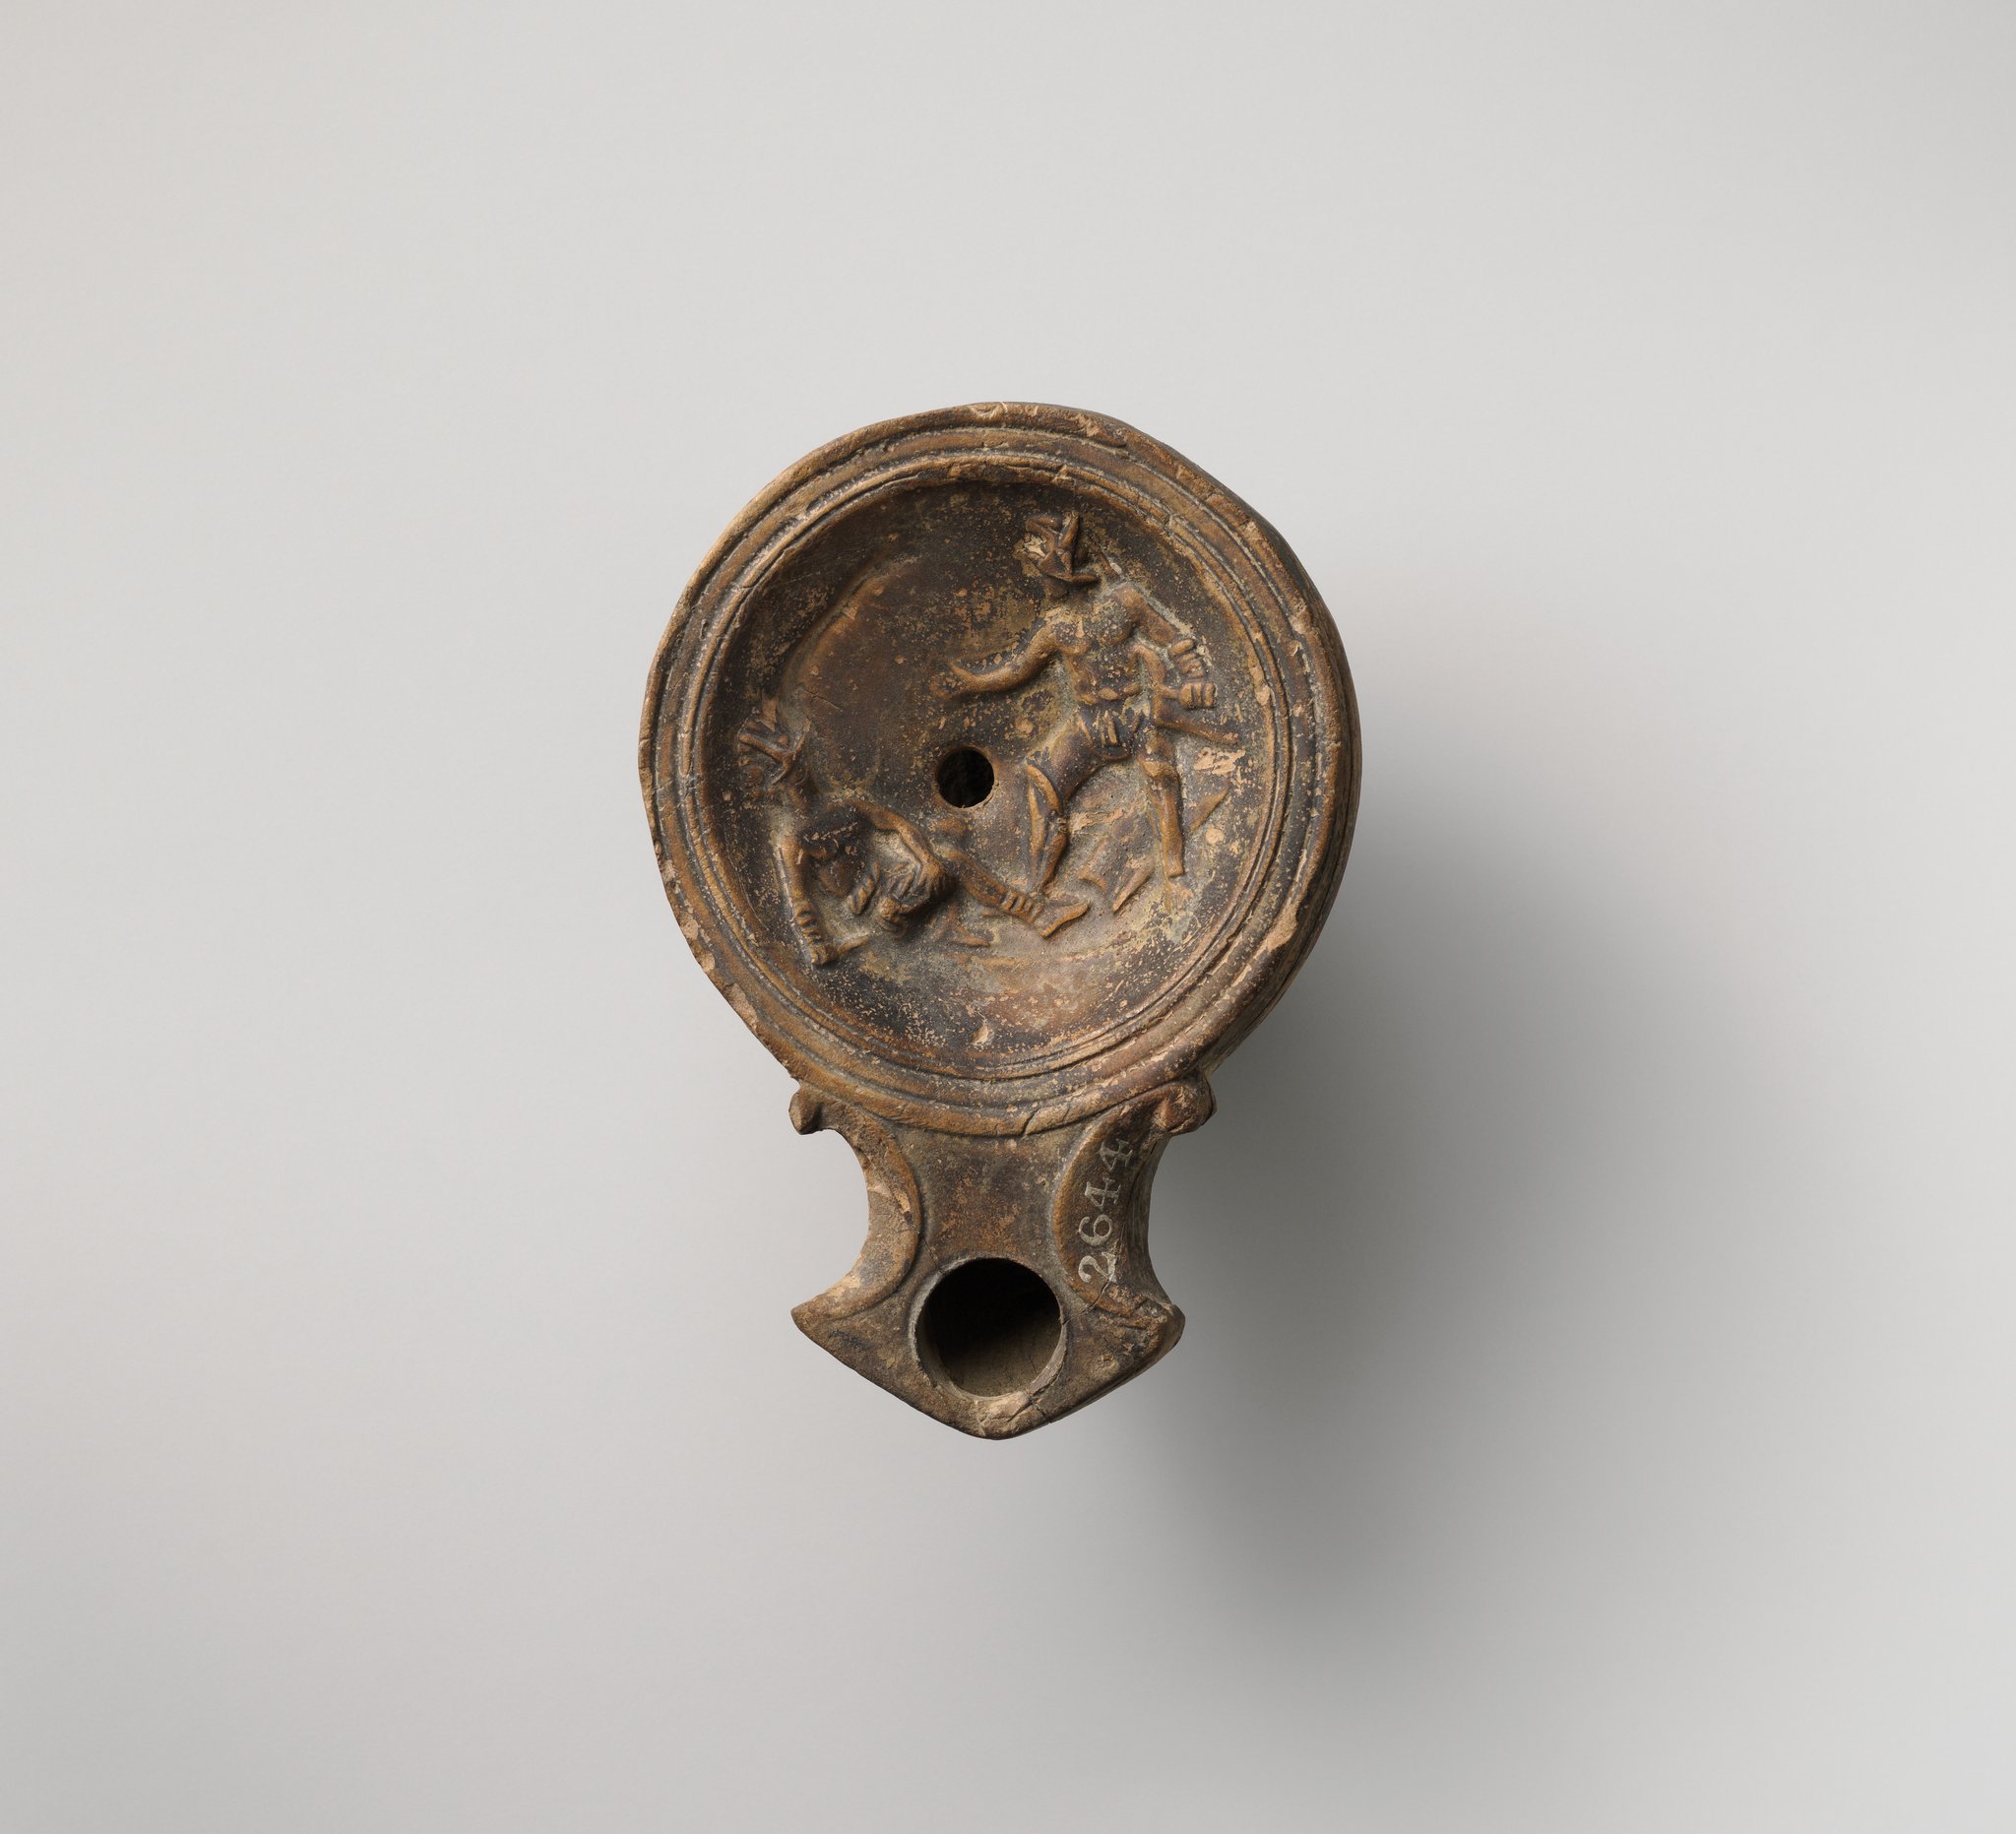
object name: lamp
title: Terracotta oil lamp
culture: roman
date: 34 BCE-33 CE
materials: terracotta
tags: gladiators